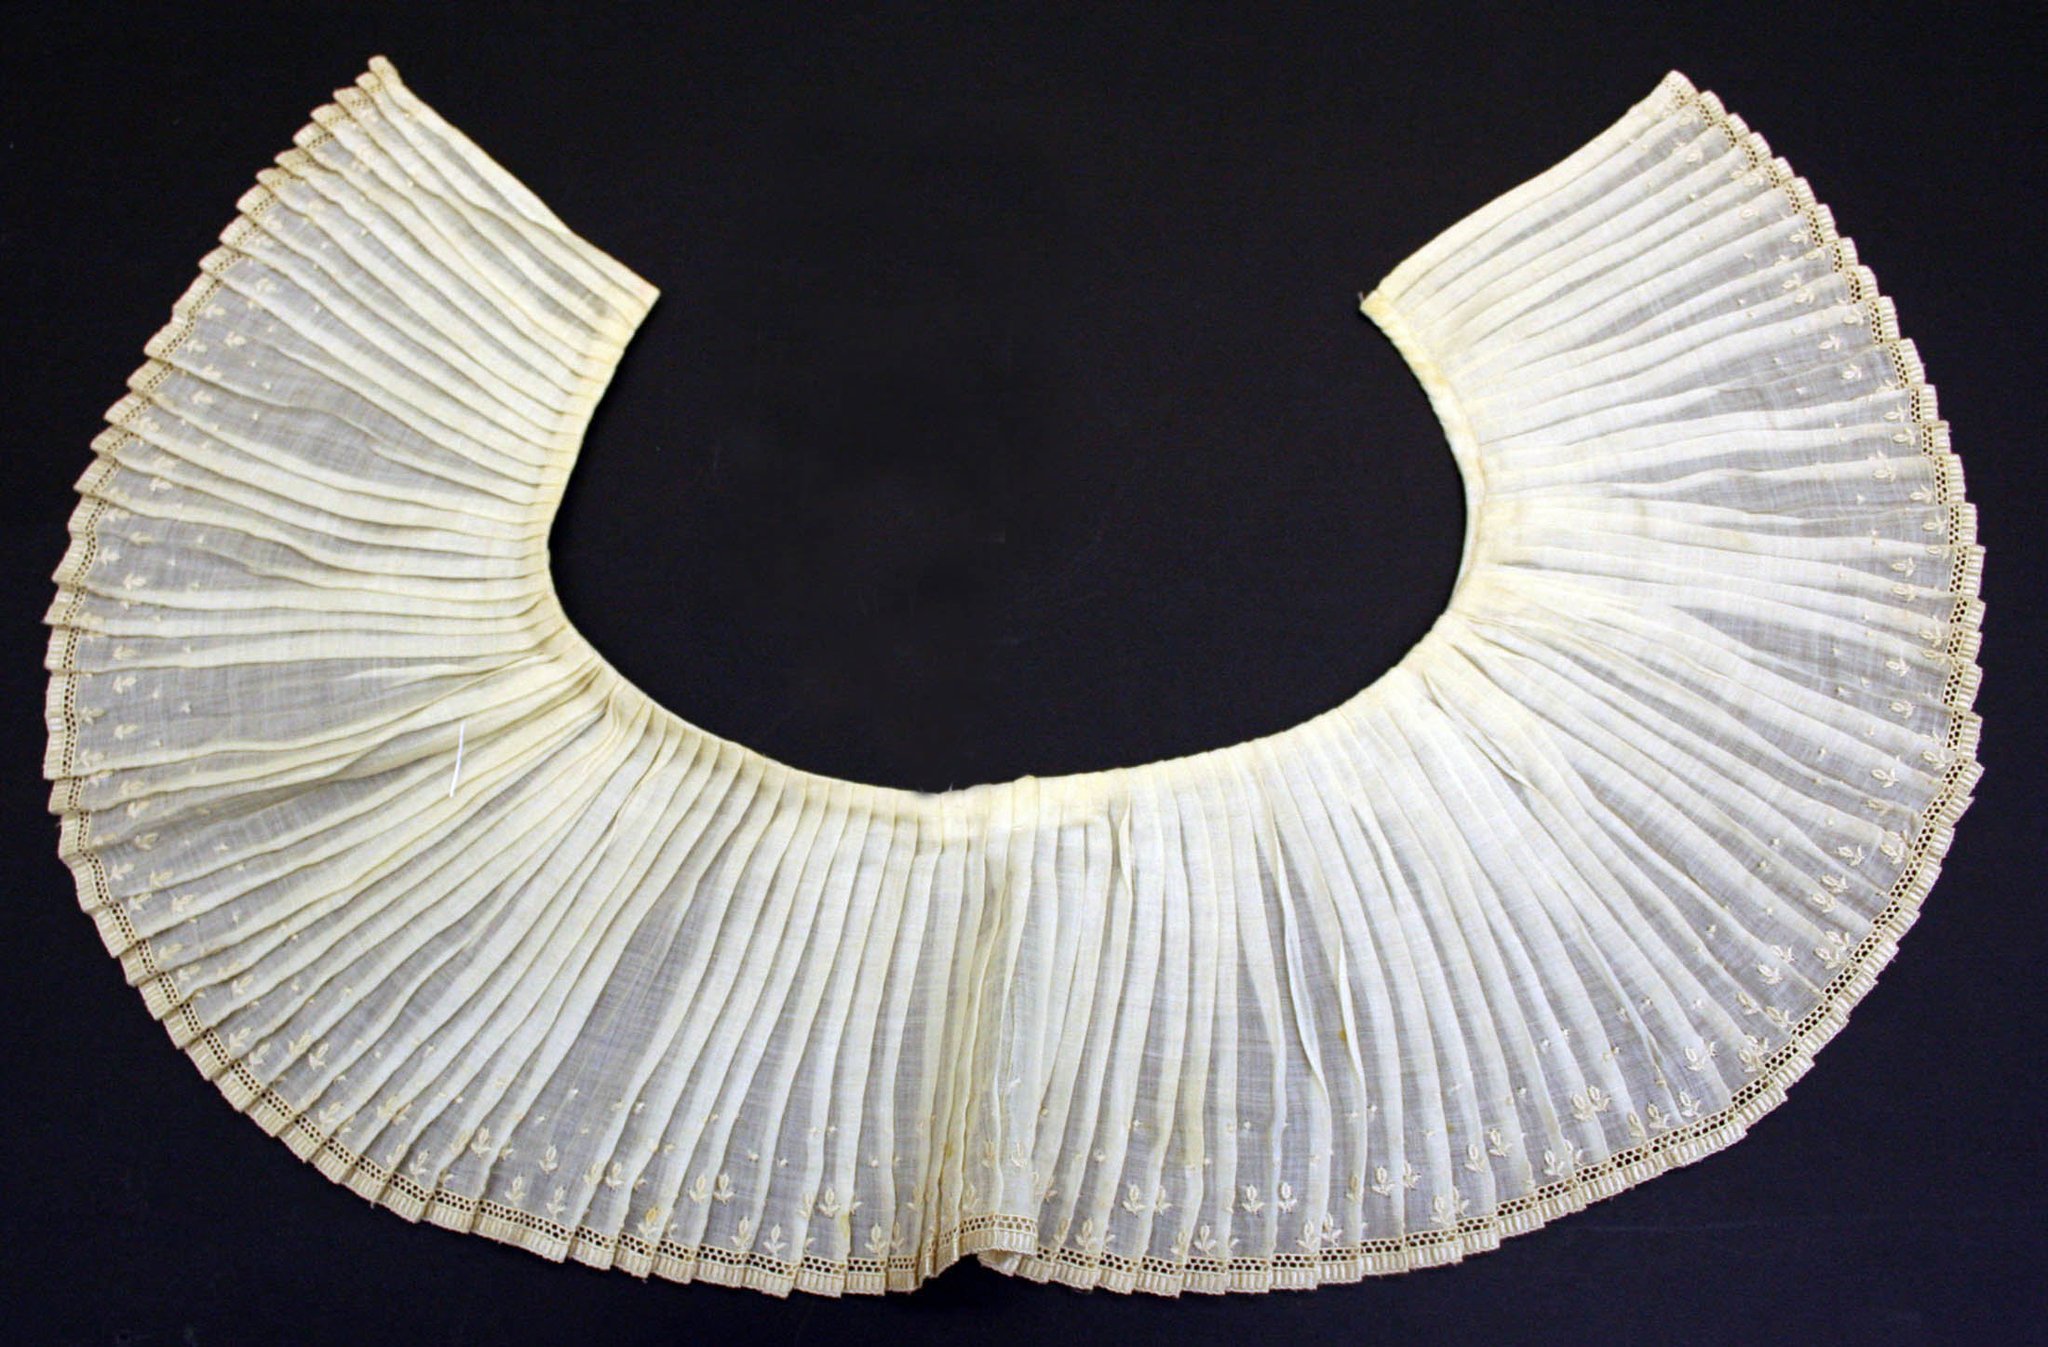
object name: collar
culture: american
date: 1900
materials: cotton